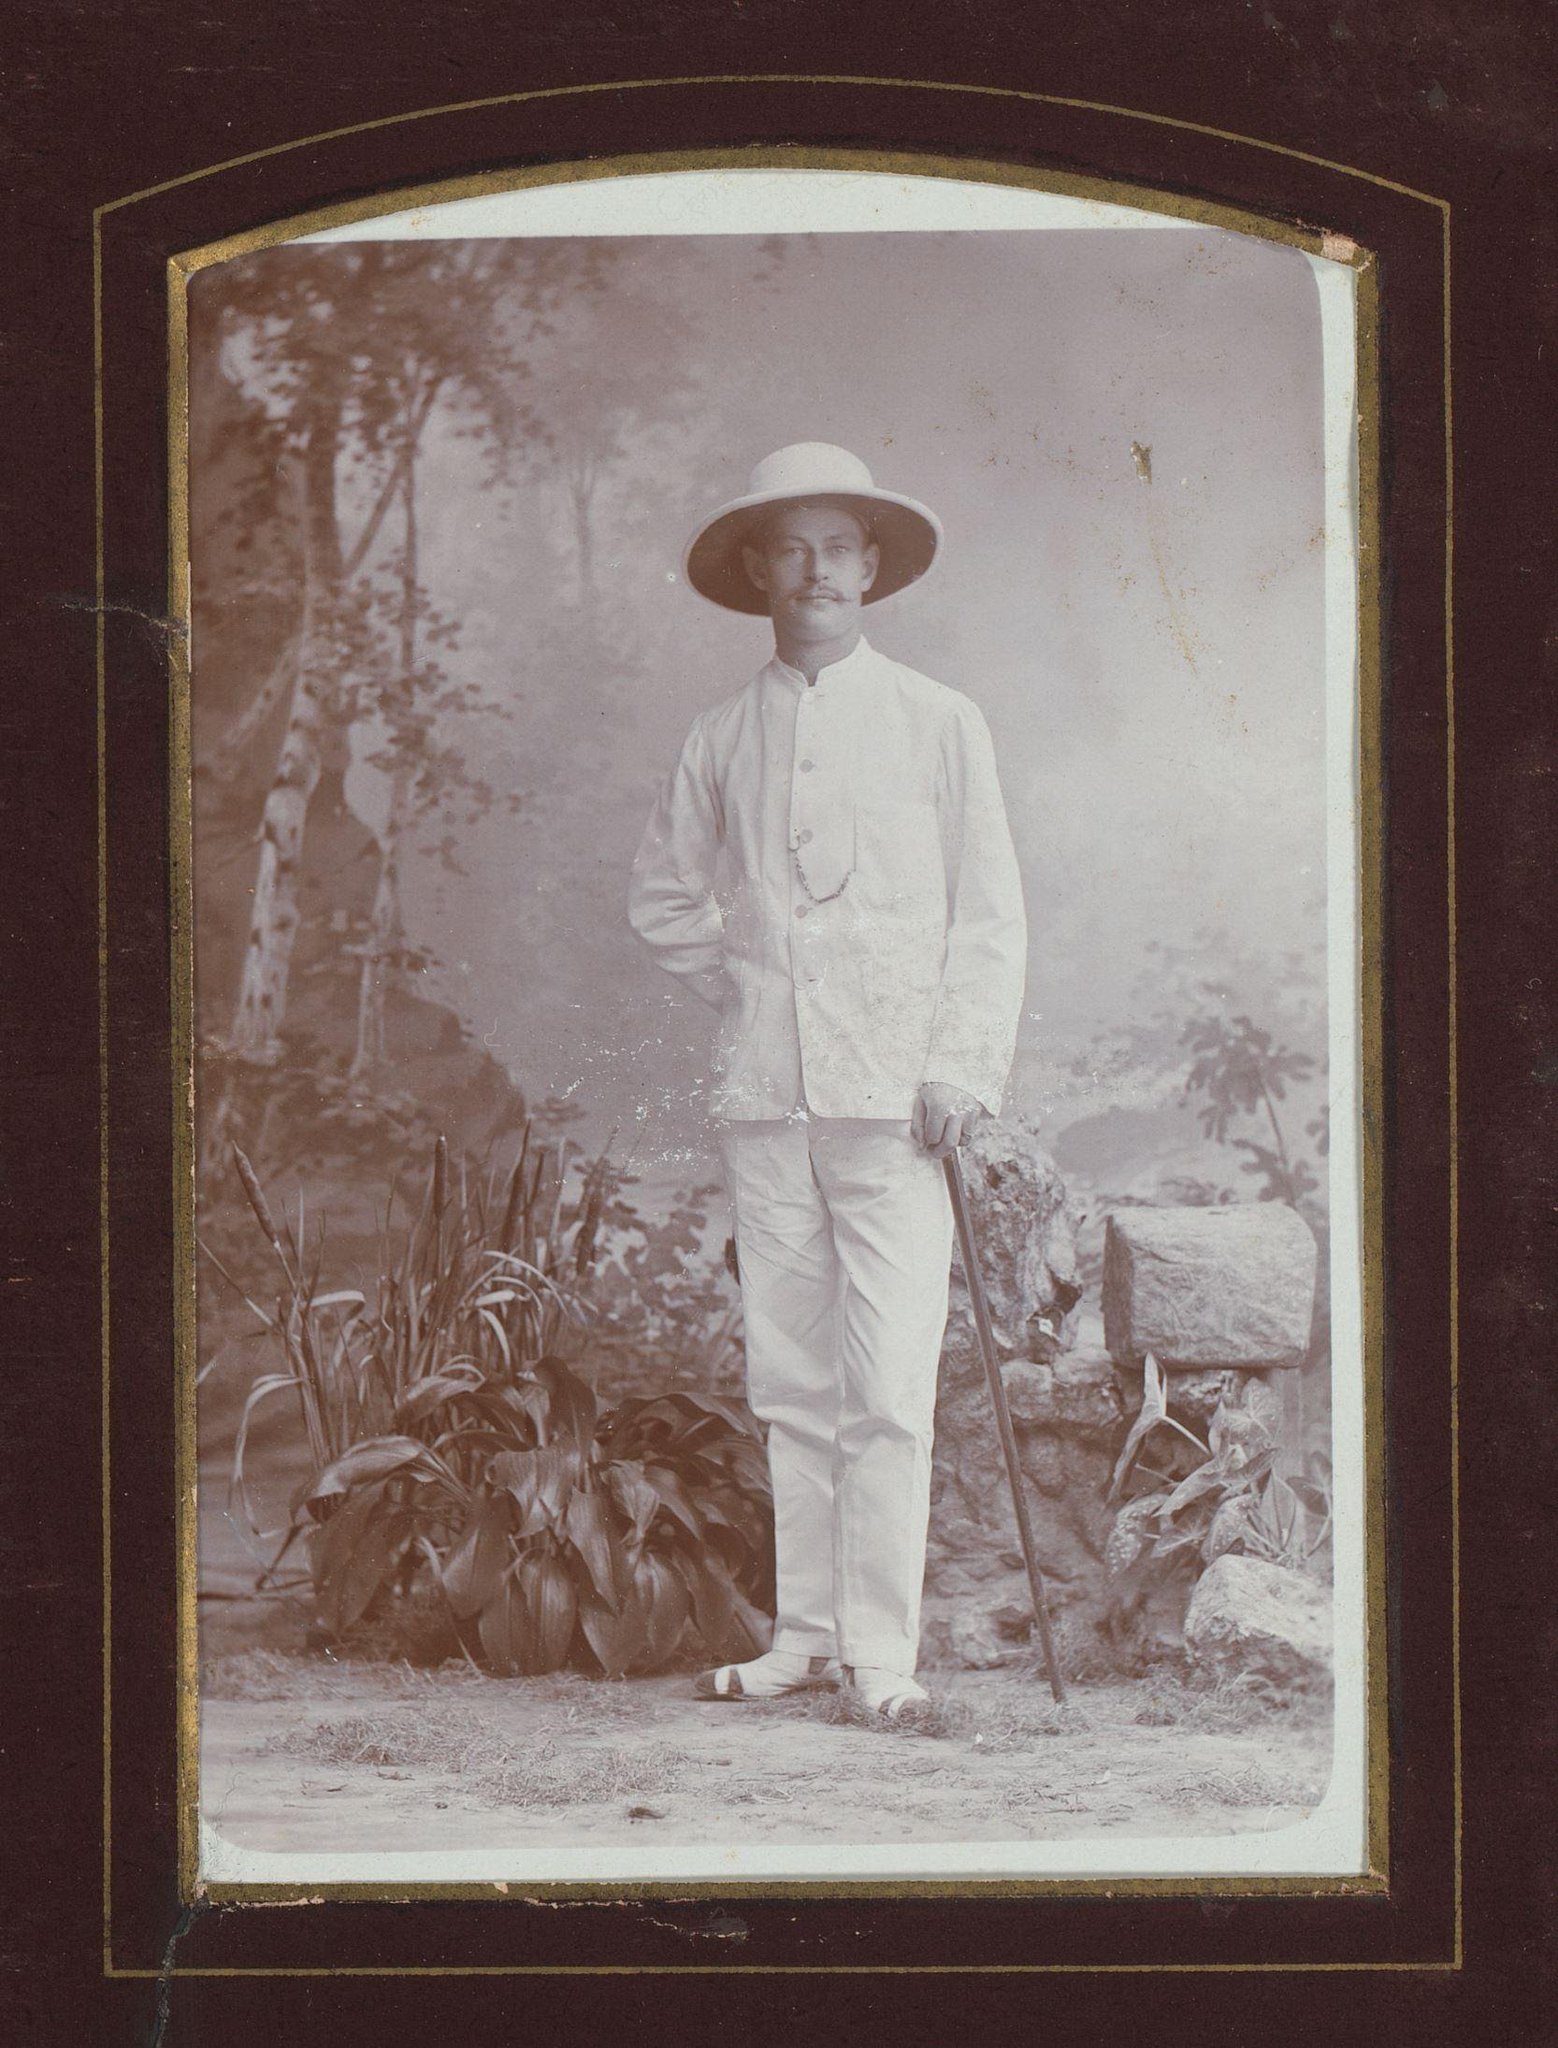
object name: photograph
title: Portret van een man in tropenkostuum met hoed en wandelstok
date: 1889-1898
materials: cardboard, photographic support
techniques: collodion silver print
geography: sumatra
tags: walking-stick, staff, historical persons, head-gear: hat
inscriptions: inscription: ‘Stafhell & Kleingrothe/ Medan Deli/ Sumatra's O.K./ Telephon No 29.’